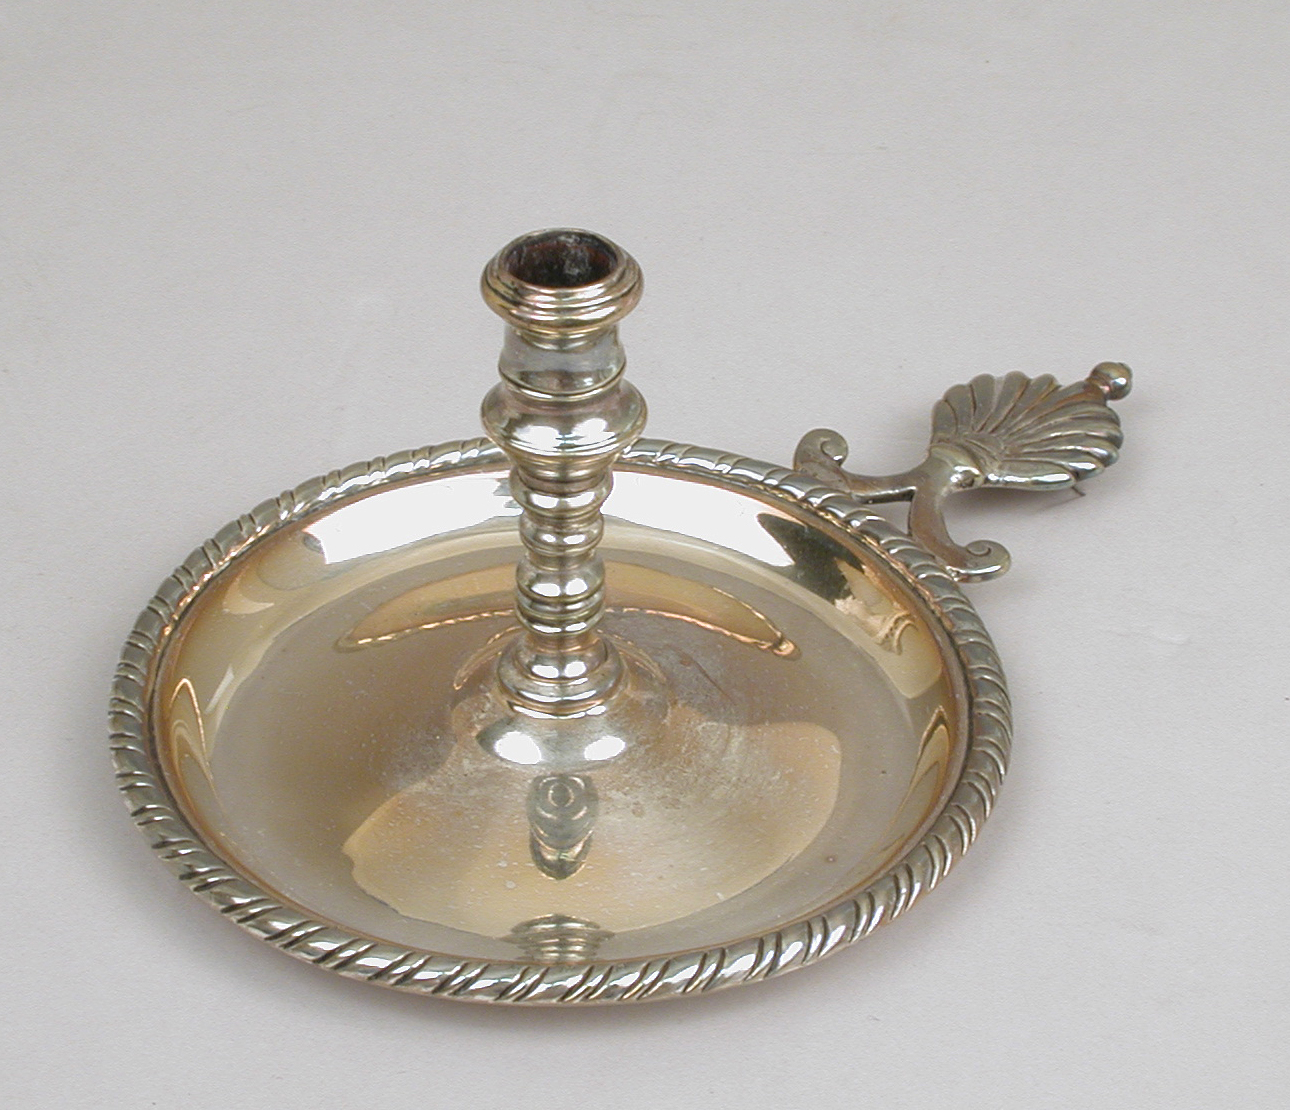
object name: taperstick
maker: simon harris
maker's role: maker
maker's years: 1750-1850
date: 1808-1809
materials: silver